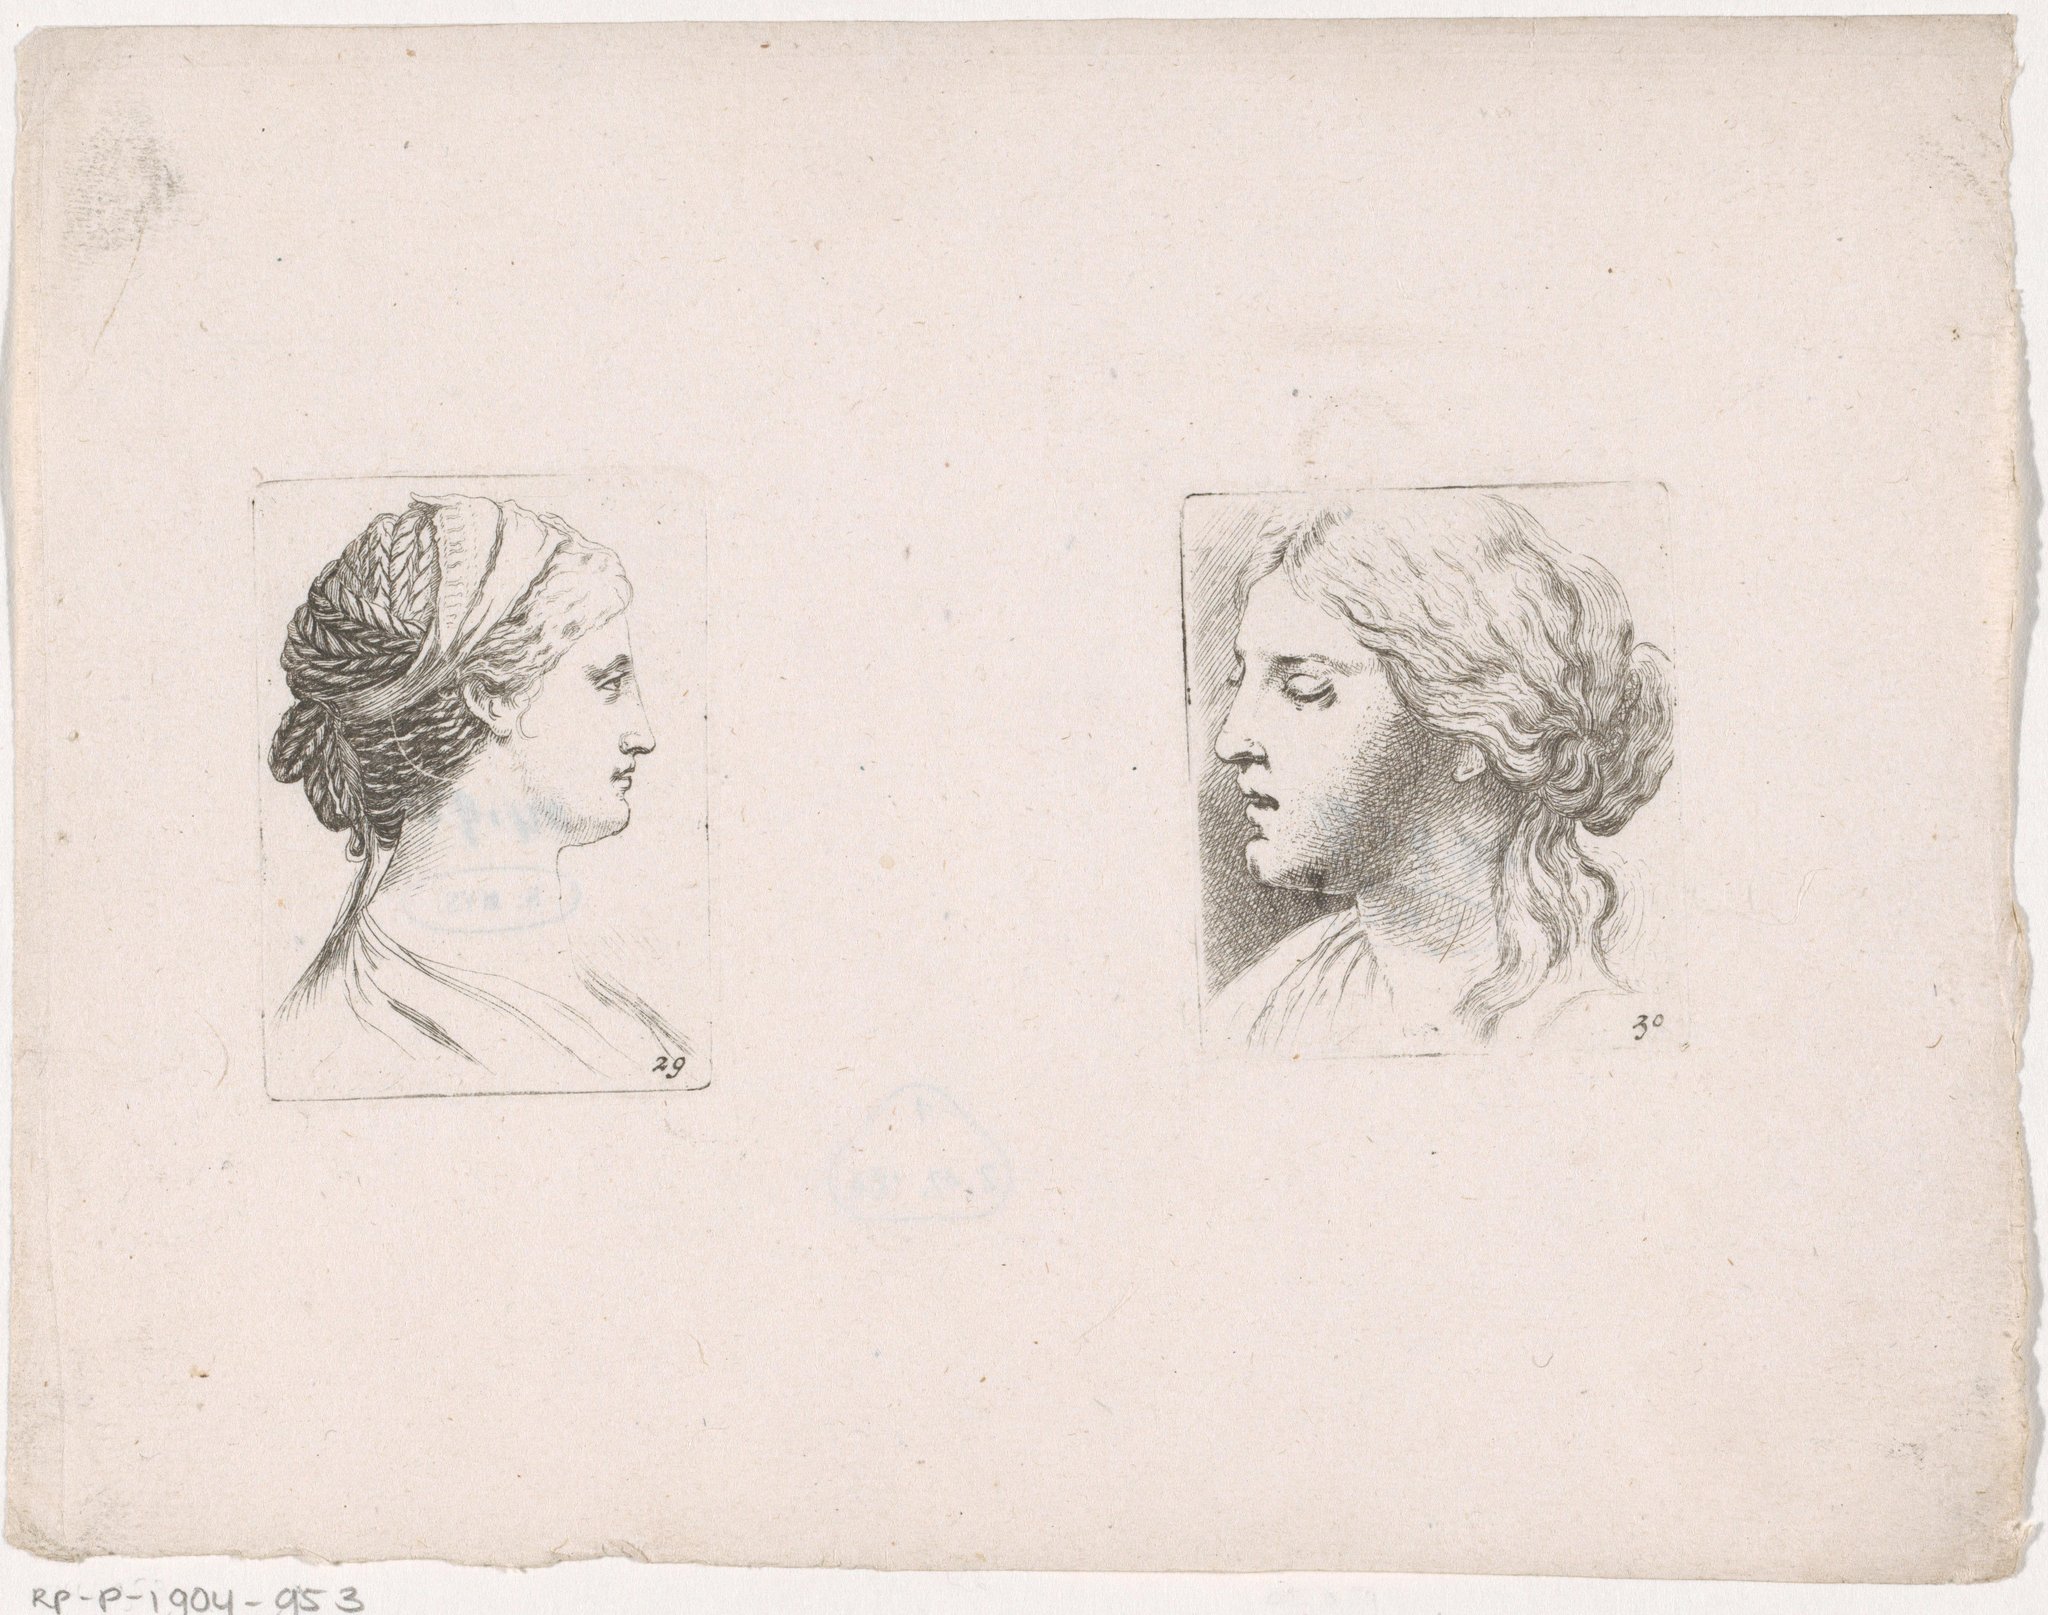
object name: print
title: Livre pour apprendre à dessiner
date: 1620-1664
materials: paper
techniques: etching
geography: amsterdam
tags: adult woman, head (human) (+ sideview, profile)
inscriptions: collector's mark: Lugt 2228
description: Blad met twee voorstellingen. Links: hoofd van een vrouw met gevlochten haar in profiel naar rechts. Rechts: hoofd van een vrouw met gesloten ogen naar links gewend.